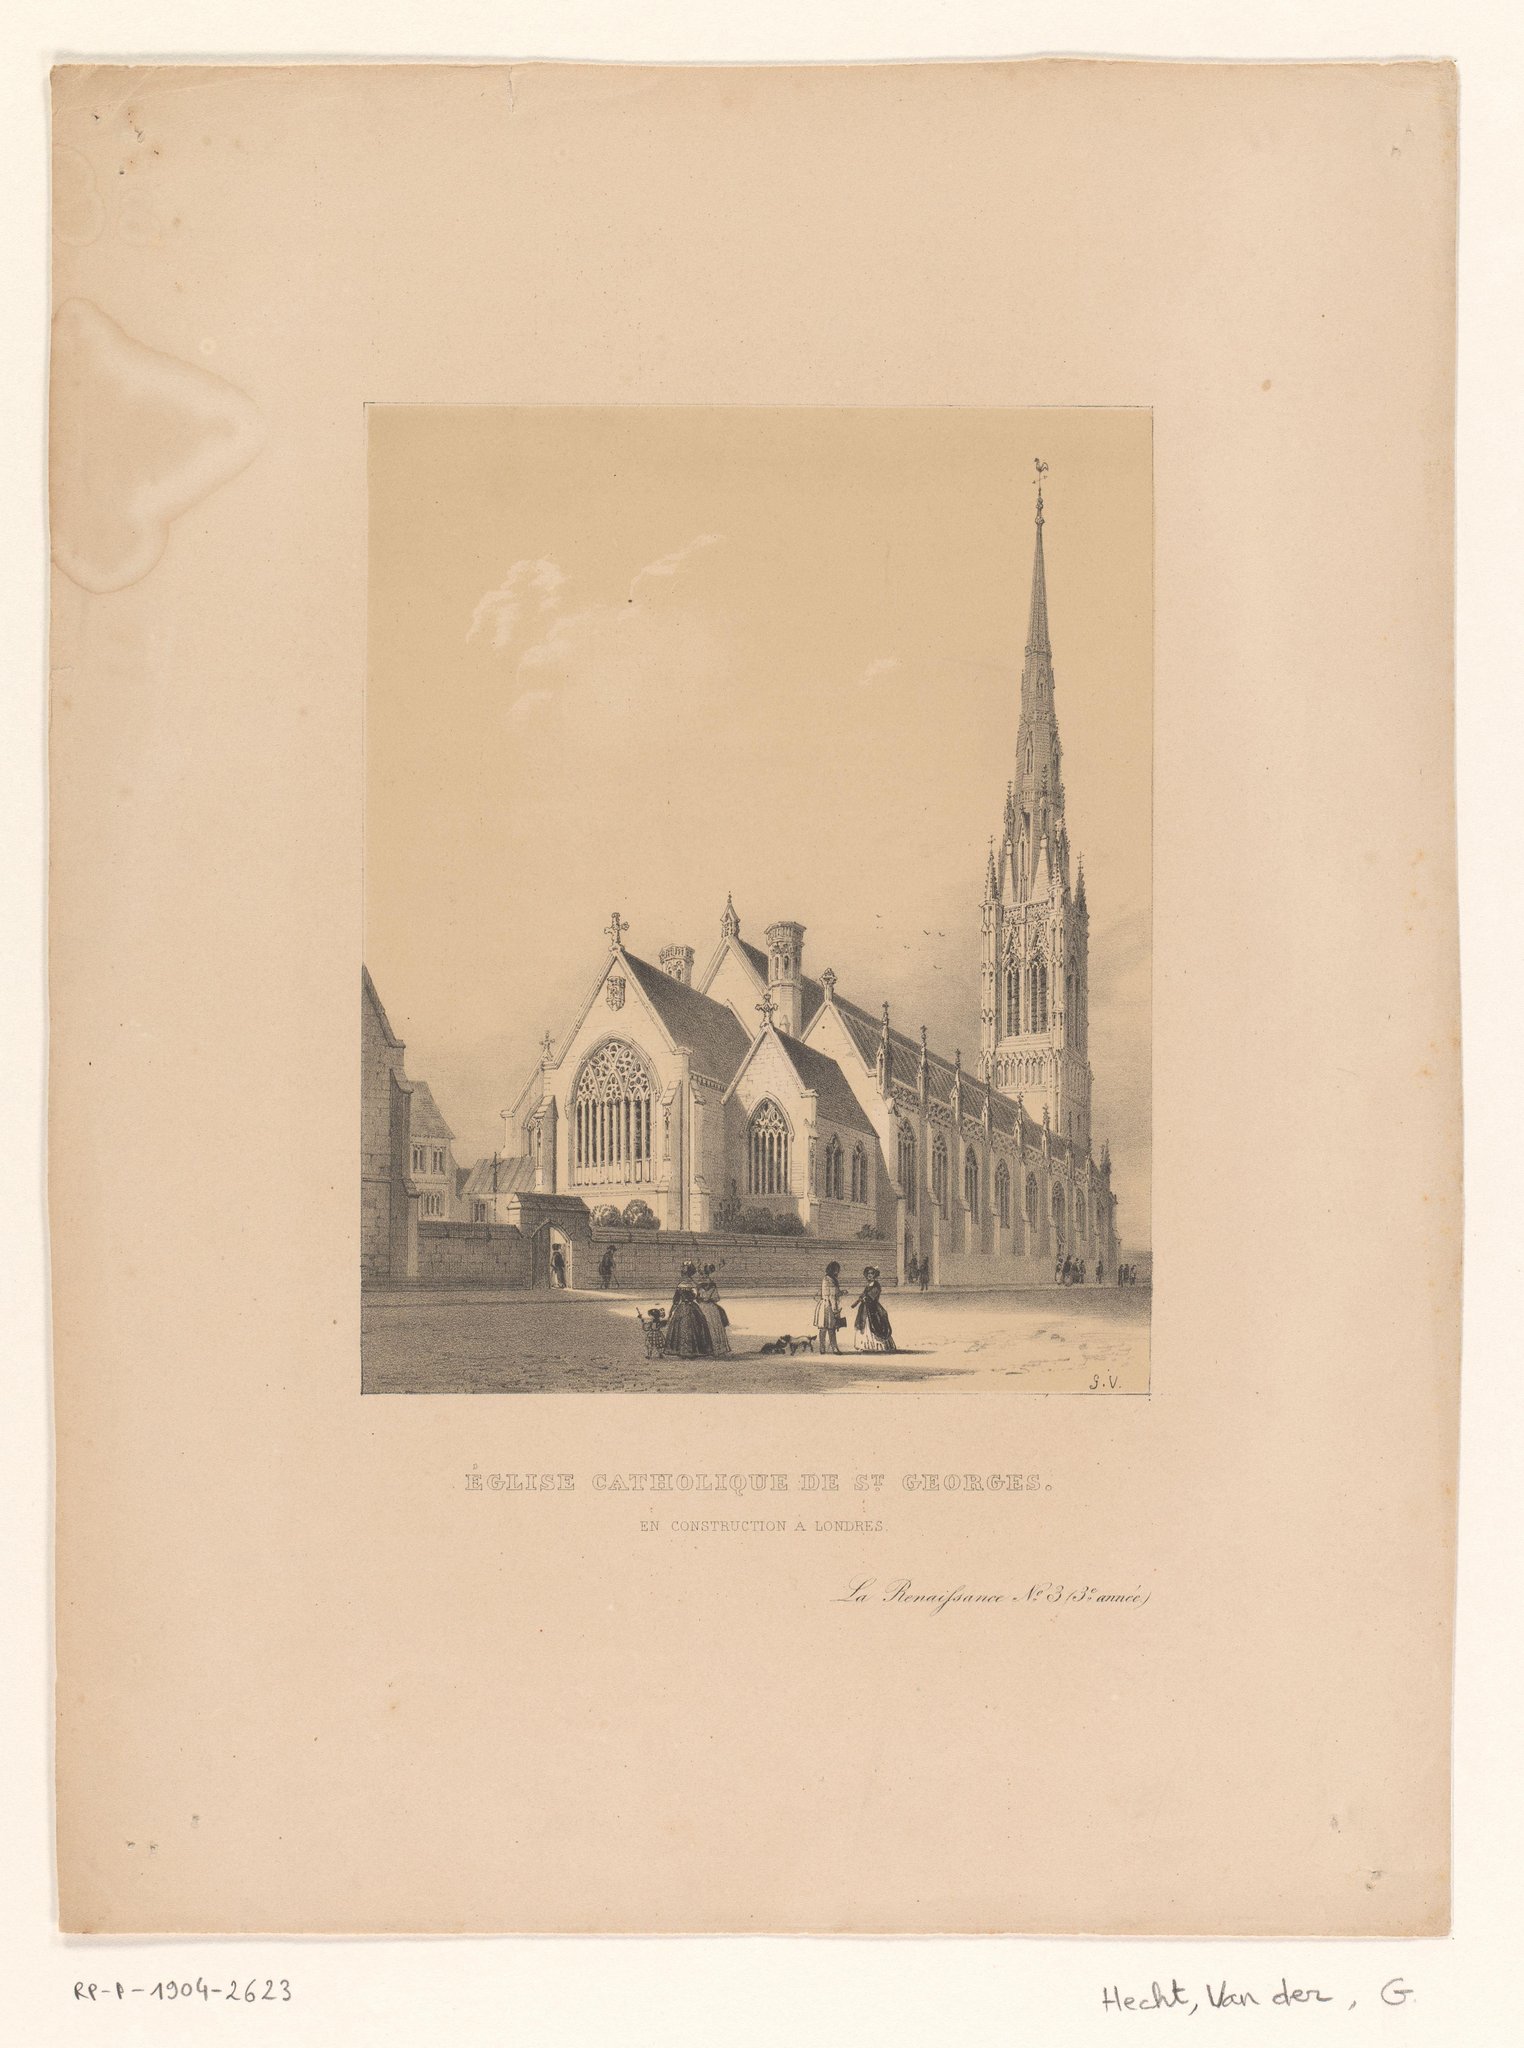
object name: print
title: Église catholique de St. Georges. En contruction a Londres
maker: guillaume van der hecht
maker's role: print maker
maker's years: 1817-1891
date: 1841-1842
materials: paper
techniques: tone lithography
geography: brussels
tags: church (exterior), city-view, and landscape with man-made constructions (+ city(-scape) with figures, staffage), london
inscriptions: collector's mark: Lugt 2228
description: Prent uit: La Renaissance. Chronique des arts et de la littérature 3 (1841-1842), pl. 3.